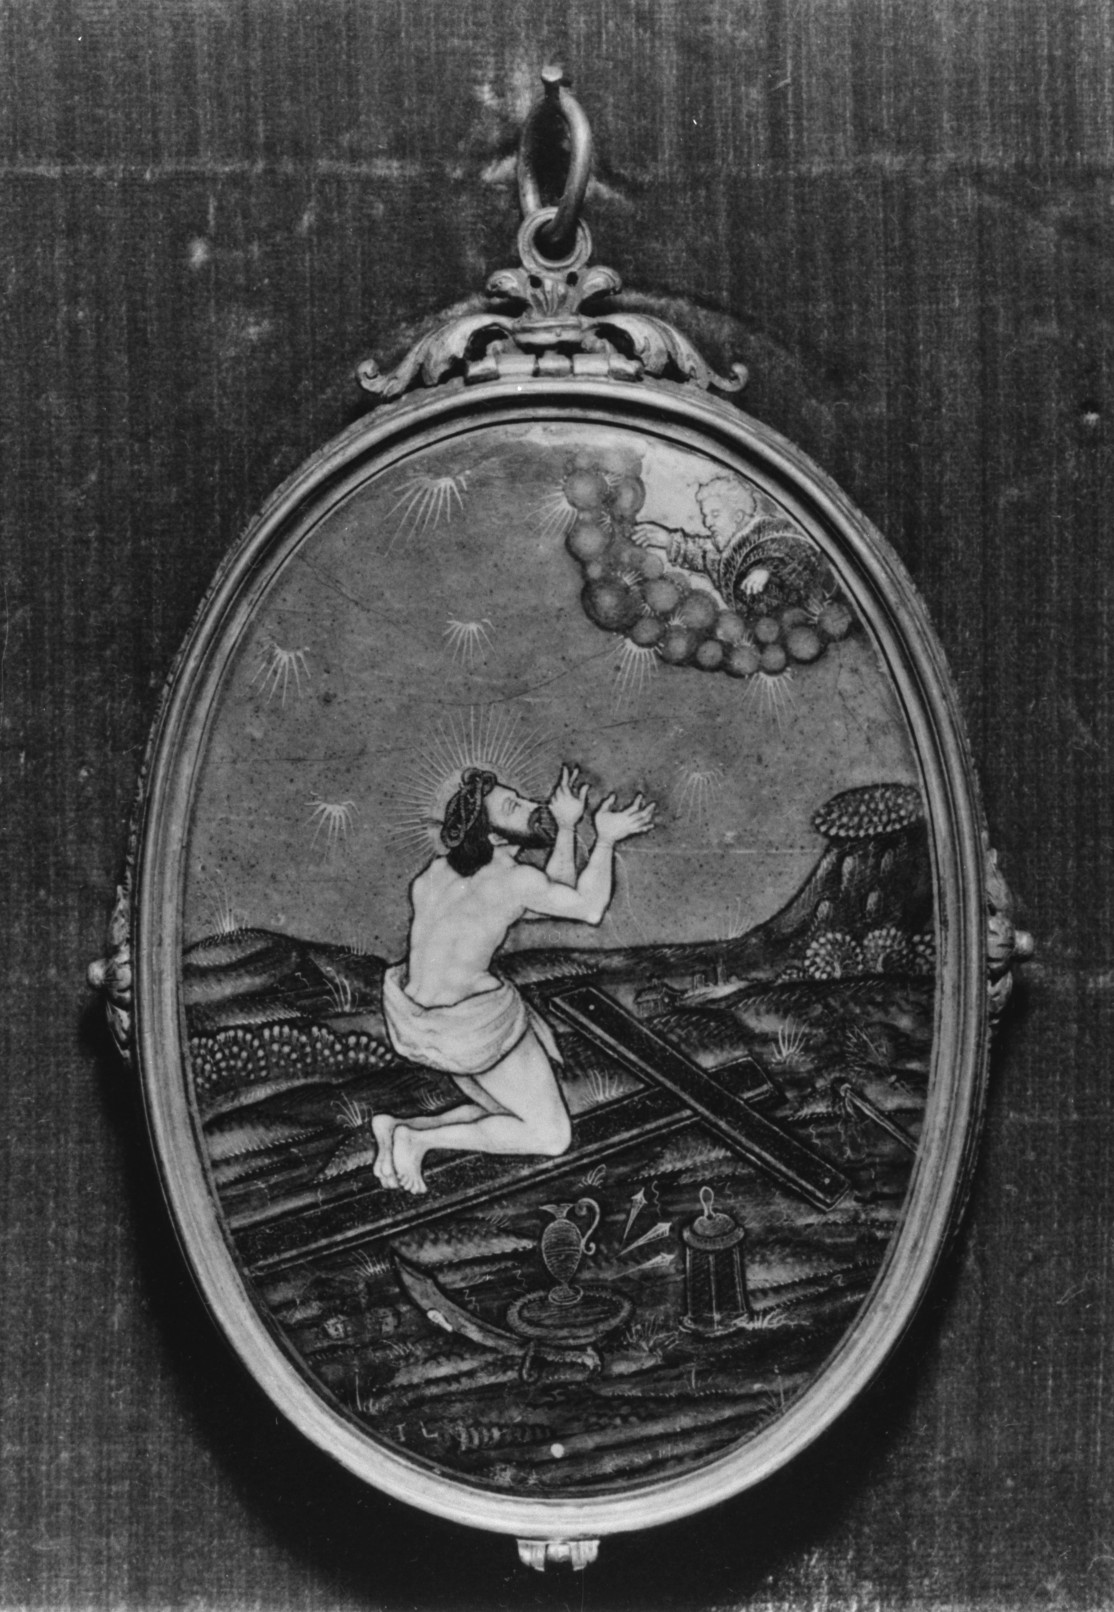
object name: mirror back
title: God the Father Appearing to Christ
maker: jean limosin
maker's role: enameler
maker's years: 1615-1635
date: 1601-1633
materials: copper, enamel, gilt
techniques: painting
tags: christ,god the father